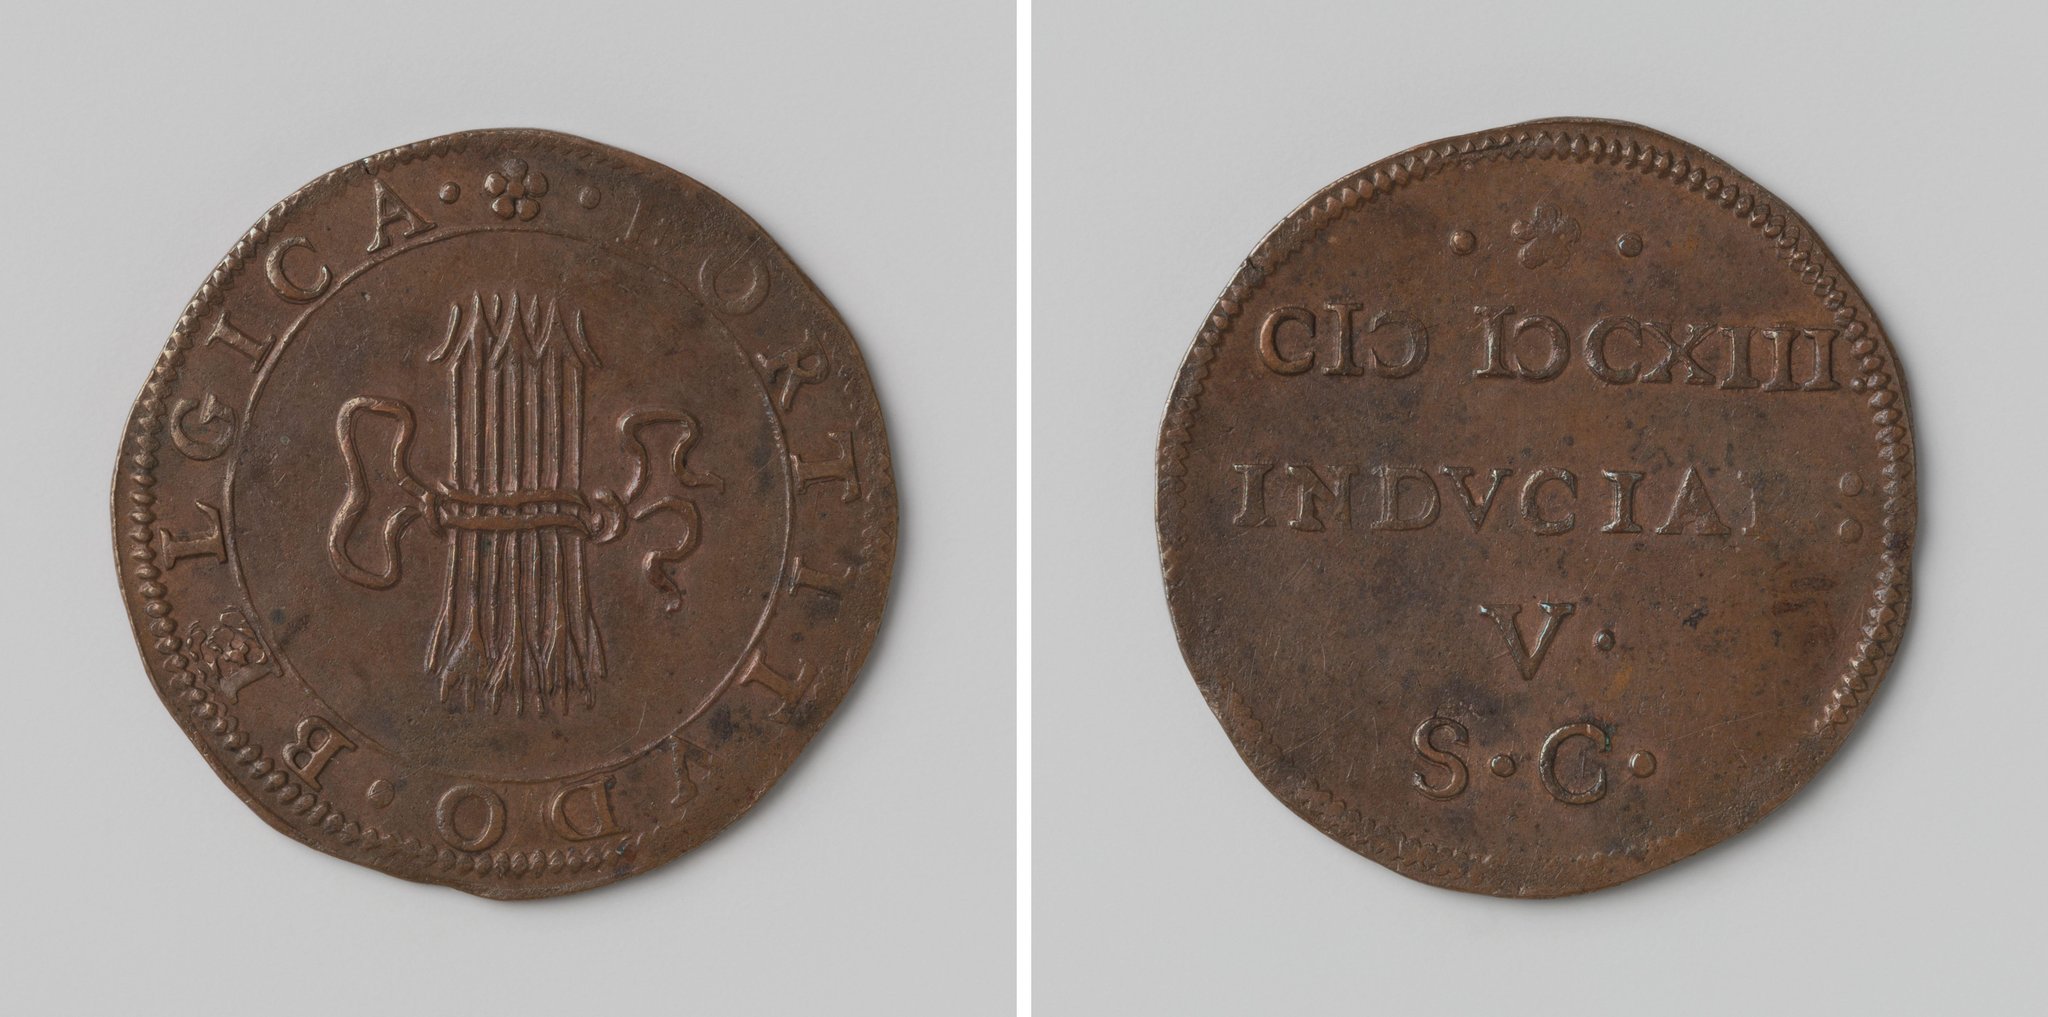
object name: jeton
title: Macht van de Zeven Verenigde Nederlanden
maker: Anonymous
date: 1613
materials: copper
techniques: striking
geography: dordrecht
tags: netherlands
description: Koperen penning. Voorzijde: bundel van zee met lint samengebonden pijlen binnen omschrift. Keerzijde: opschrift